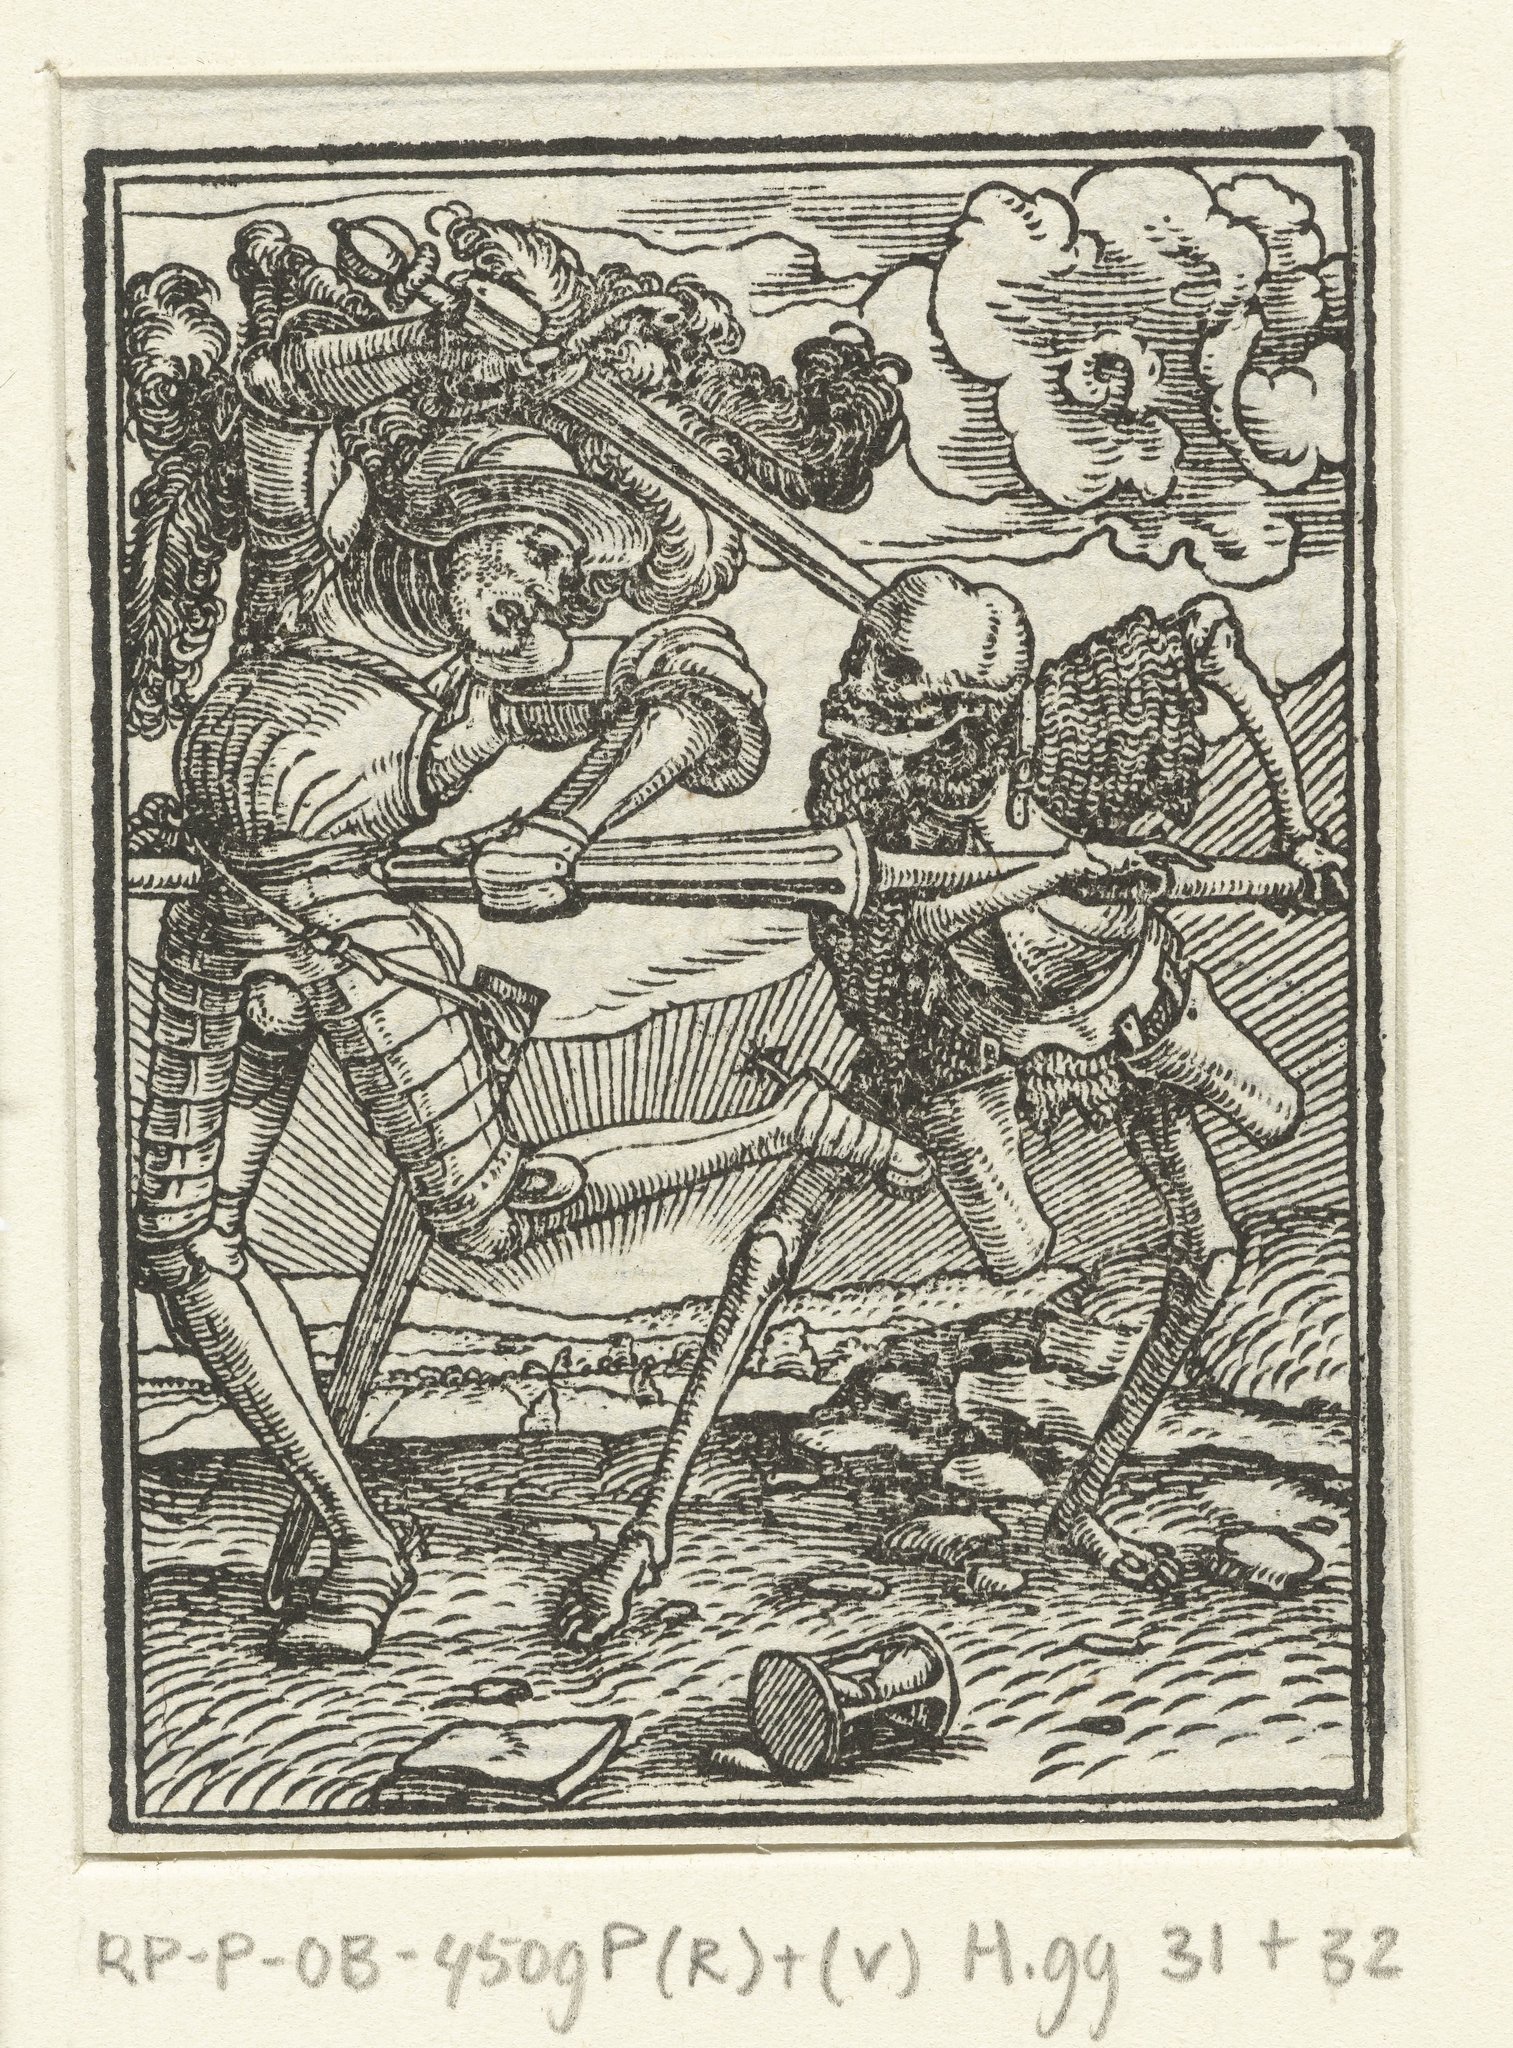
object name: book illustration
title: Dodendans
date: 1524-1526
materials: paper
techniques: woodcut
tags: dance of death; death together with one or more human beings, knight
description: De houtblokken werden voor 1526 vervaardigd door Hans Lützelburg en pas in 1538 voor het eerst gebruikt als boekillustraties in: Les simulachres & historiees faces de la mort avtant elegamment pourtraictes que artificiellement imaginées... a Lyon, Soubsz l'escu de Coloigne, MDXXXVIII, (M. en G. Trechsel, voor F. Frellon in Lyon), 1538. Later verschenen nog andere uitgaven.